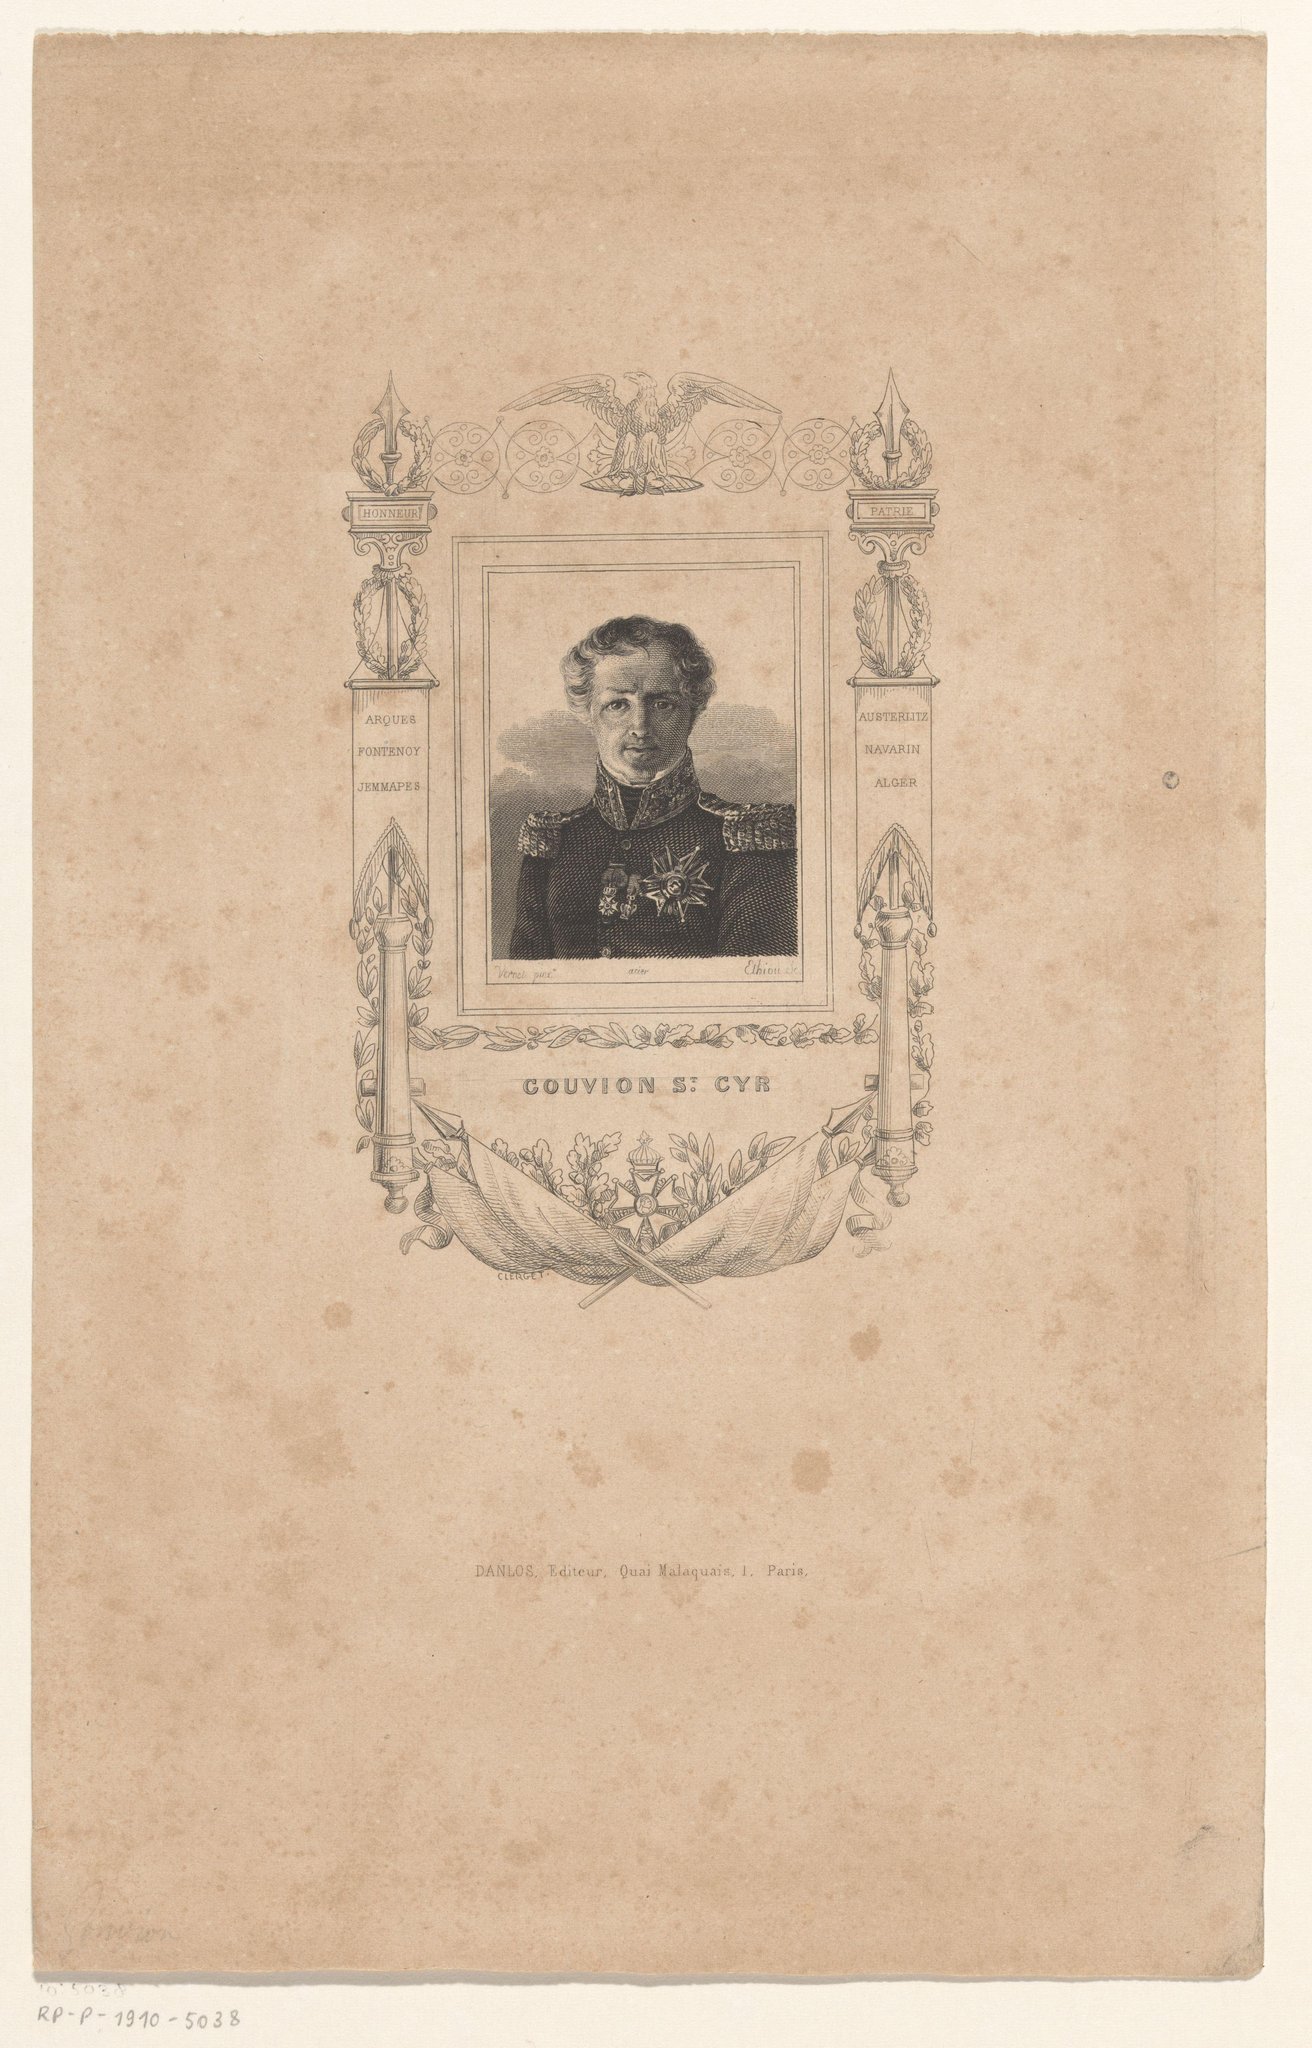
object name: print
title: Portret van Laurent de Gouvion Saint-Cyr in een versierde cartouche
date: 1815-1825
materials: paper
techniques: etching, engraving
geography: paris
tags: historical persons, ornament ~ cartouche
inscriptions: collector's mark: Lugt 2228